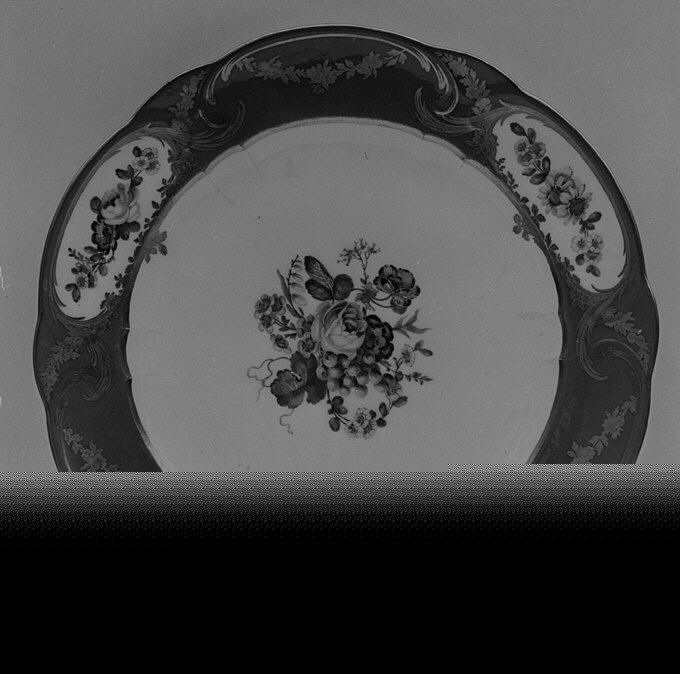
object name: plate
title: Plate (Assiette à palmes) (1 of 102) (part of a service)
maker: sèvres manufactory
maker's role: manufactory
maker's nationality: french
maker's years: 1740-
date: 1772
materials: soft paste porcelain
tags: flowers